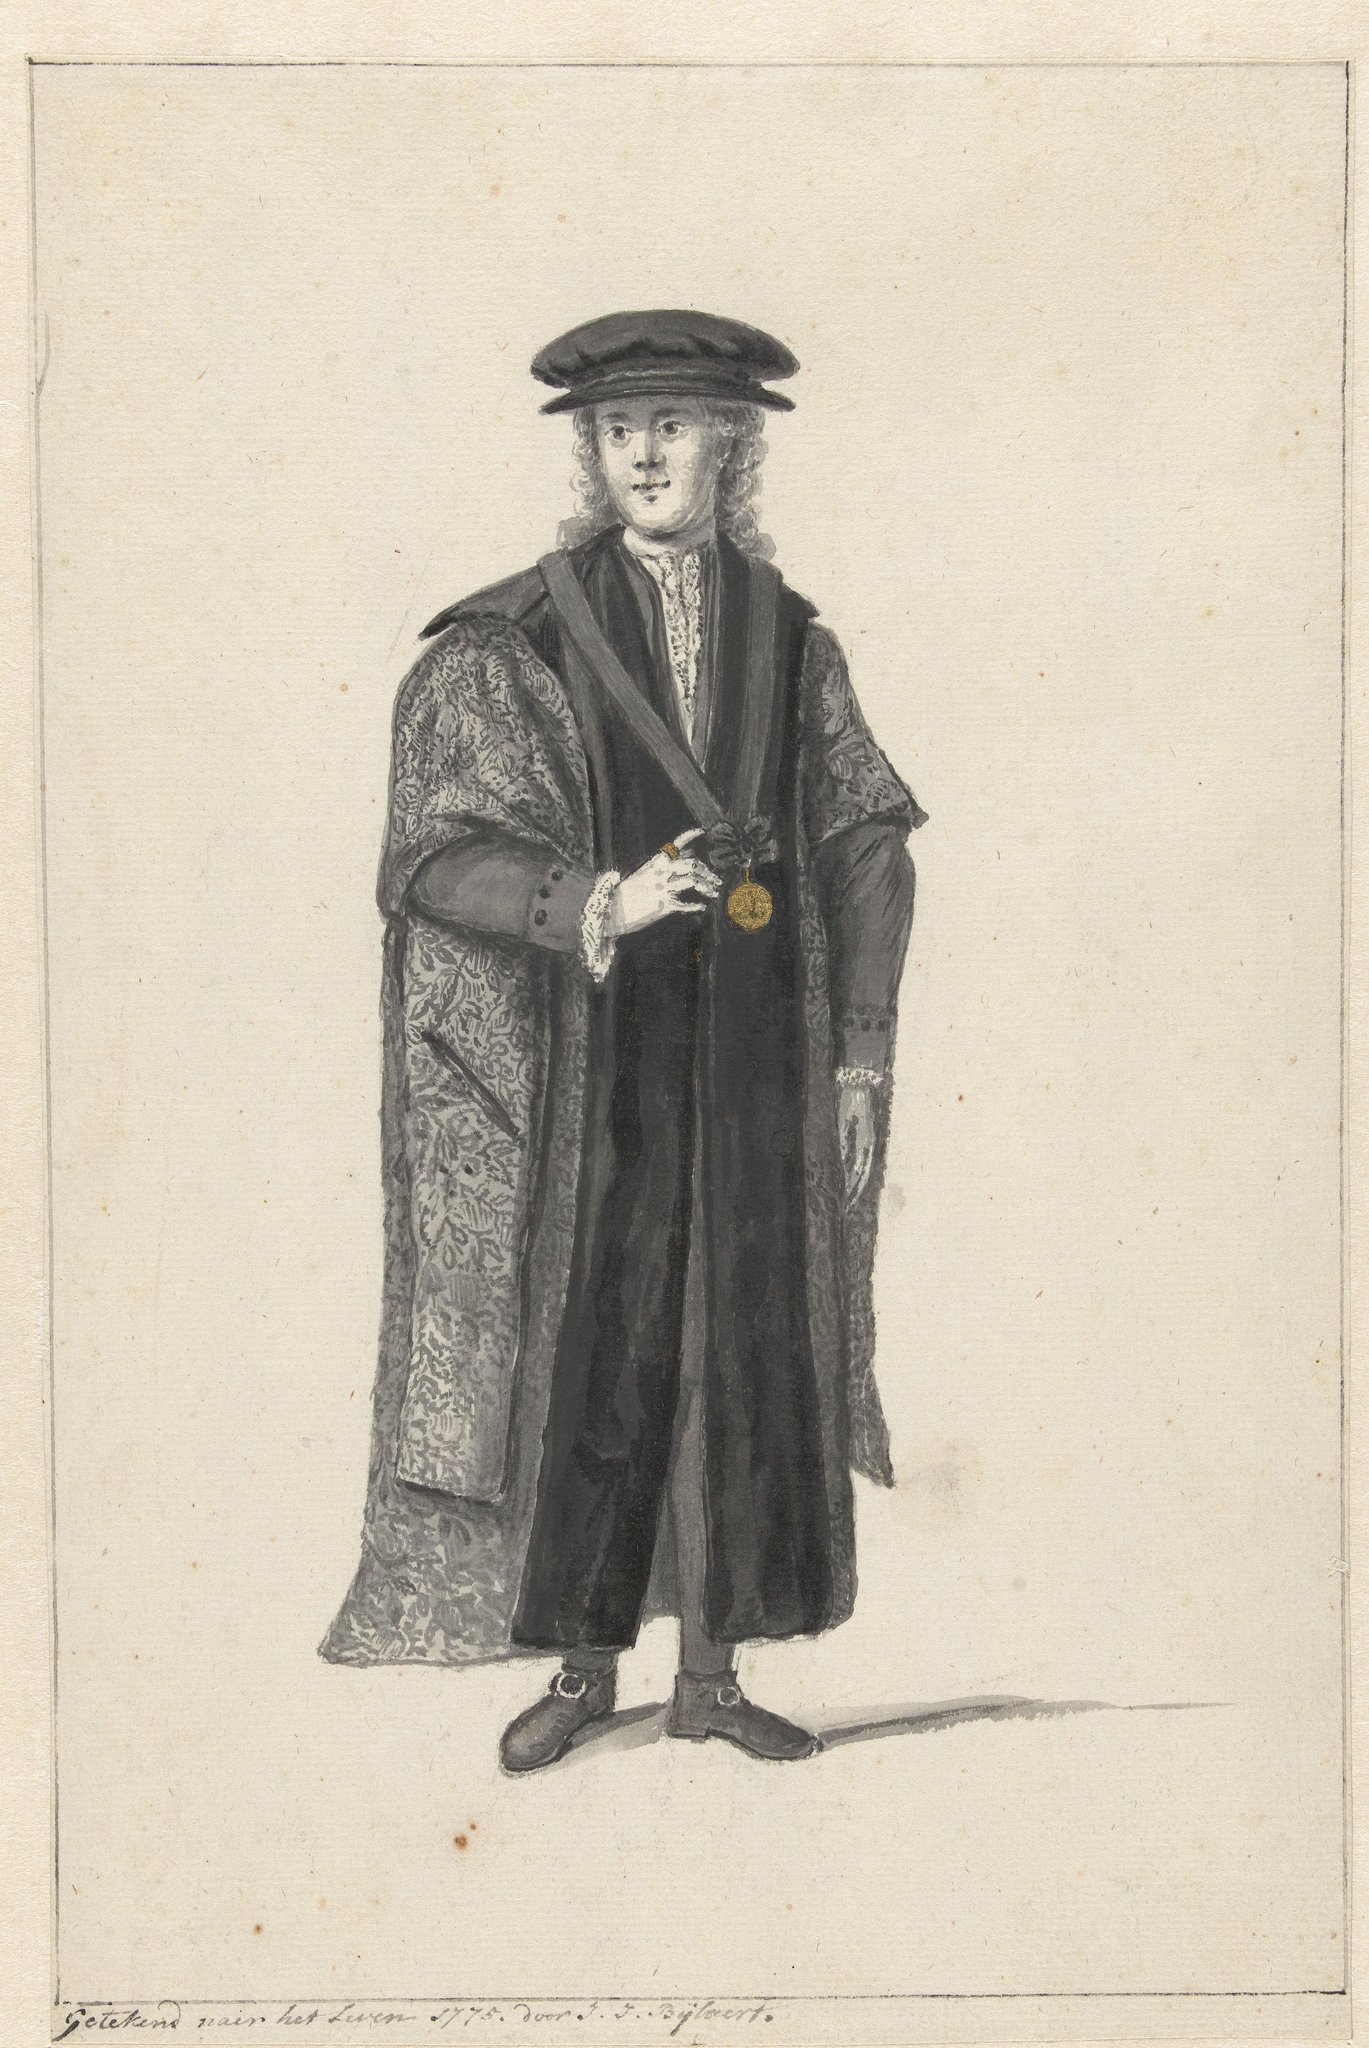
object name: drawing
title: Leidse jonge doctor met zwarte toga en erepenning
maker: joannis jacobus bijlaert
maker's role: draughtsman, print maker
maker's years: 1734-1809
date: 1775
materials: paint, paper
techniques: brush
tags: leiden